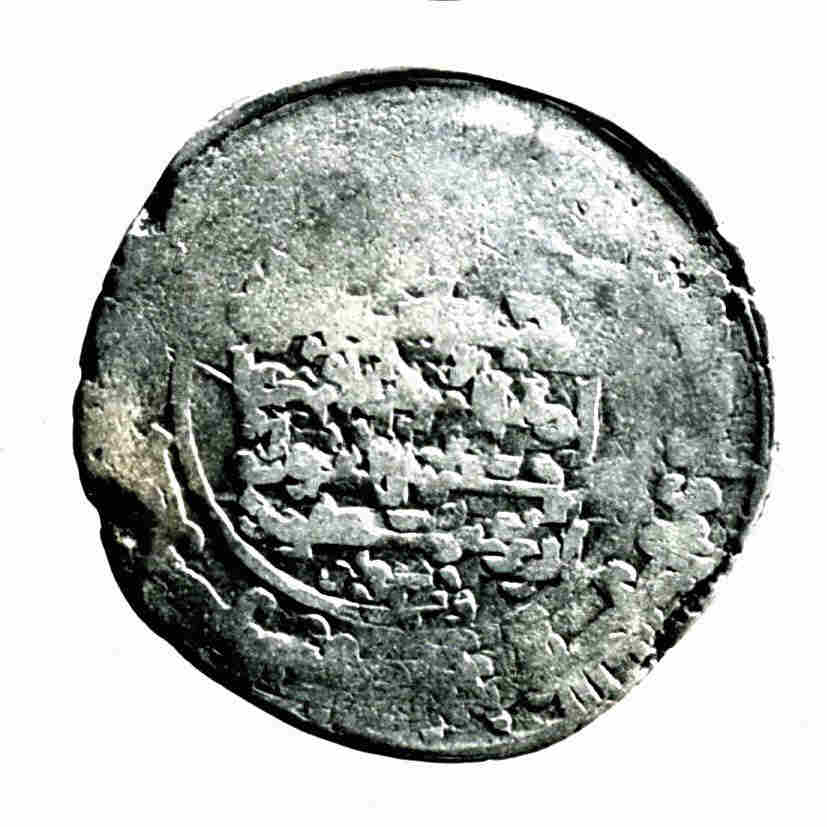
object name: coin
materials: silver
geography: iran